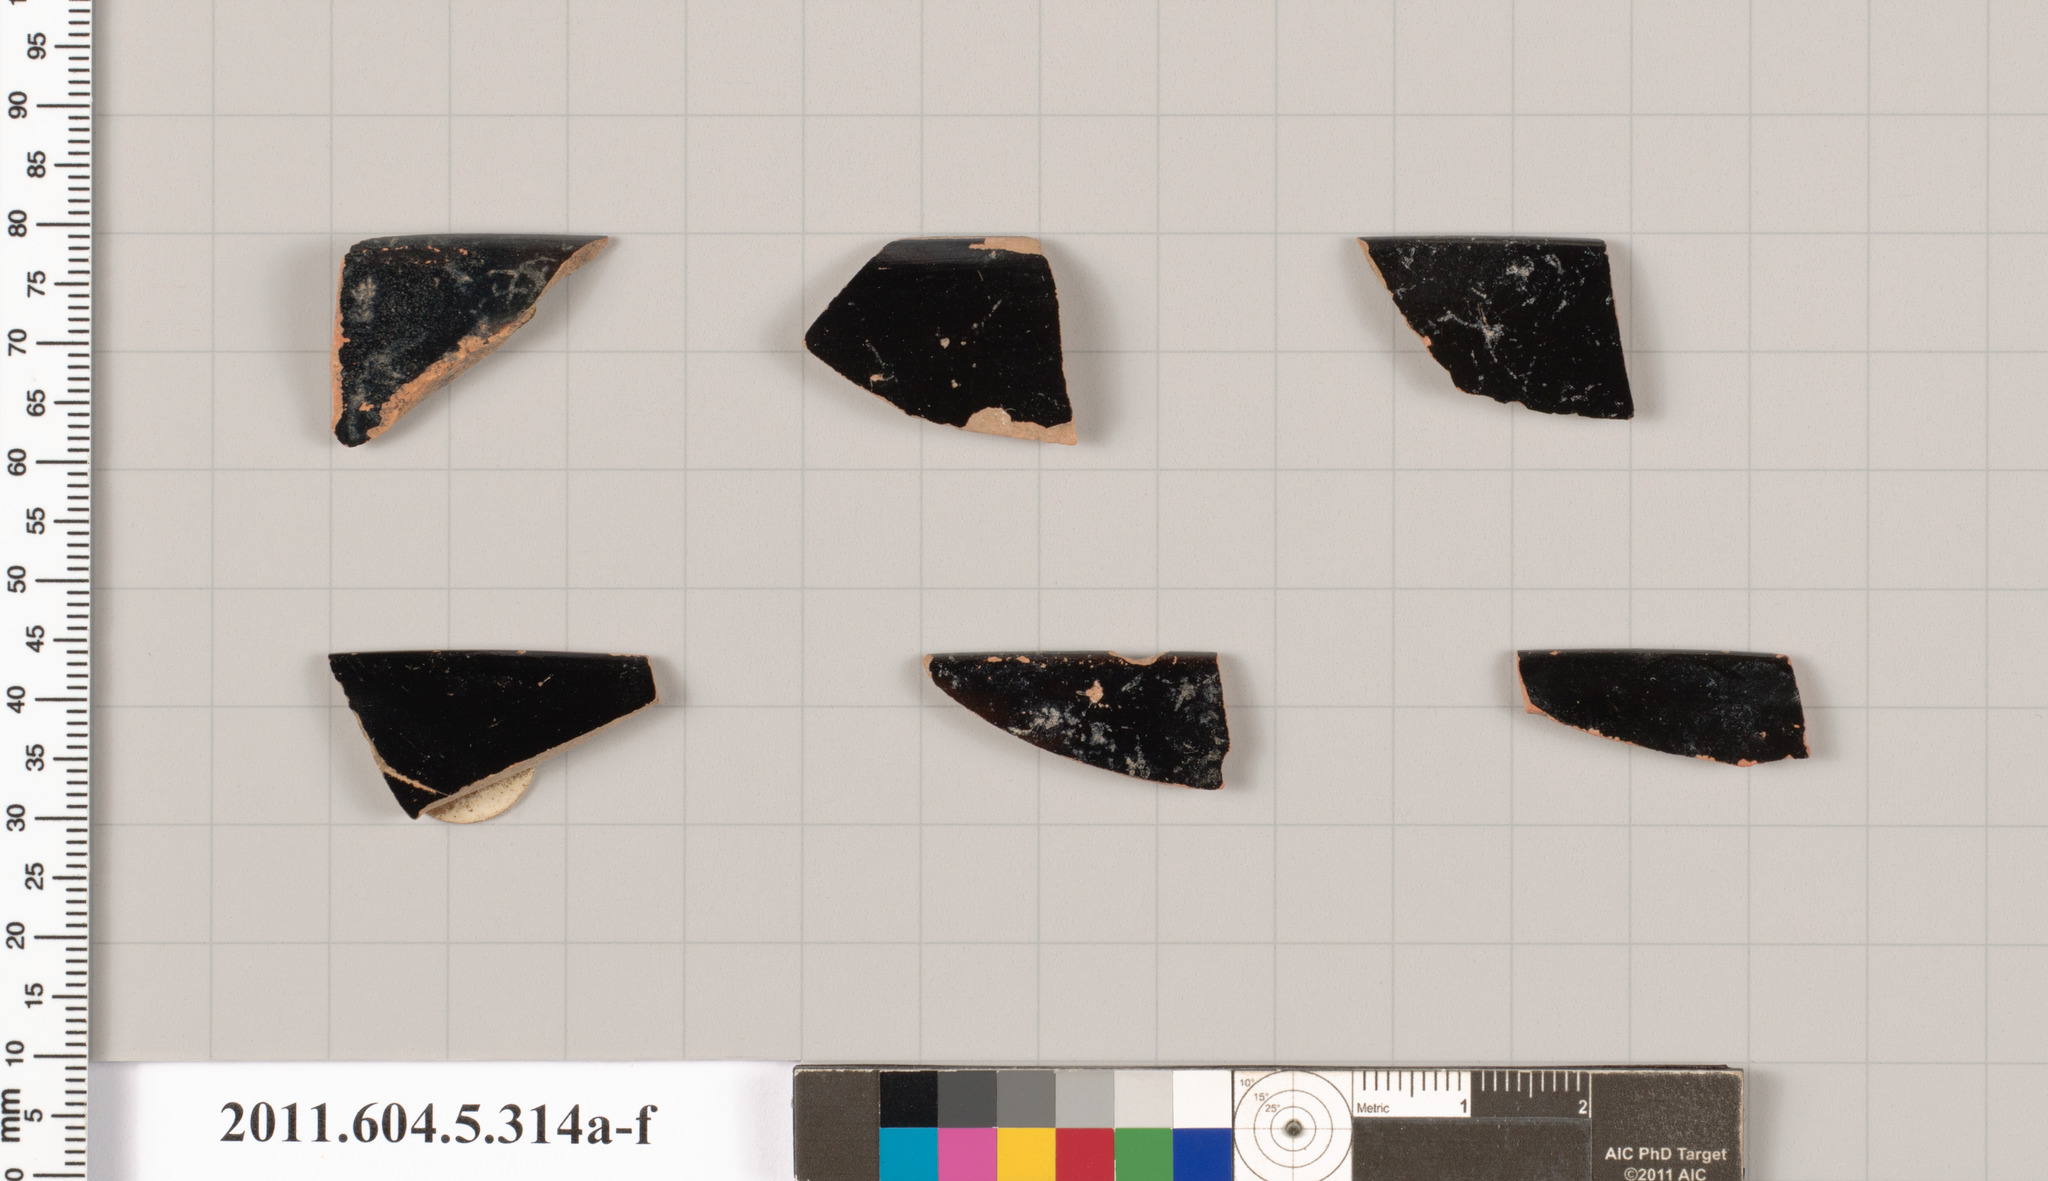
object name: kylix fragment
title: Terracotta rim fragments of kylikes (drinking cups)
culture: greek, attic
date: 600-401 BCE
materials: terracotta